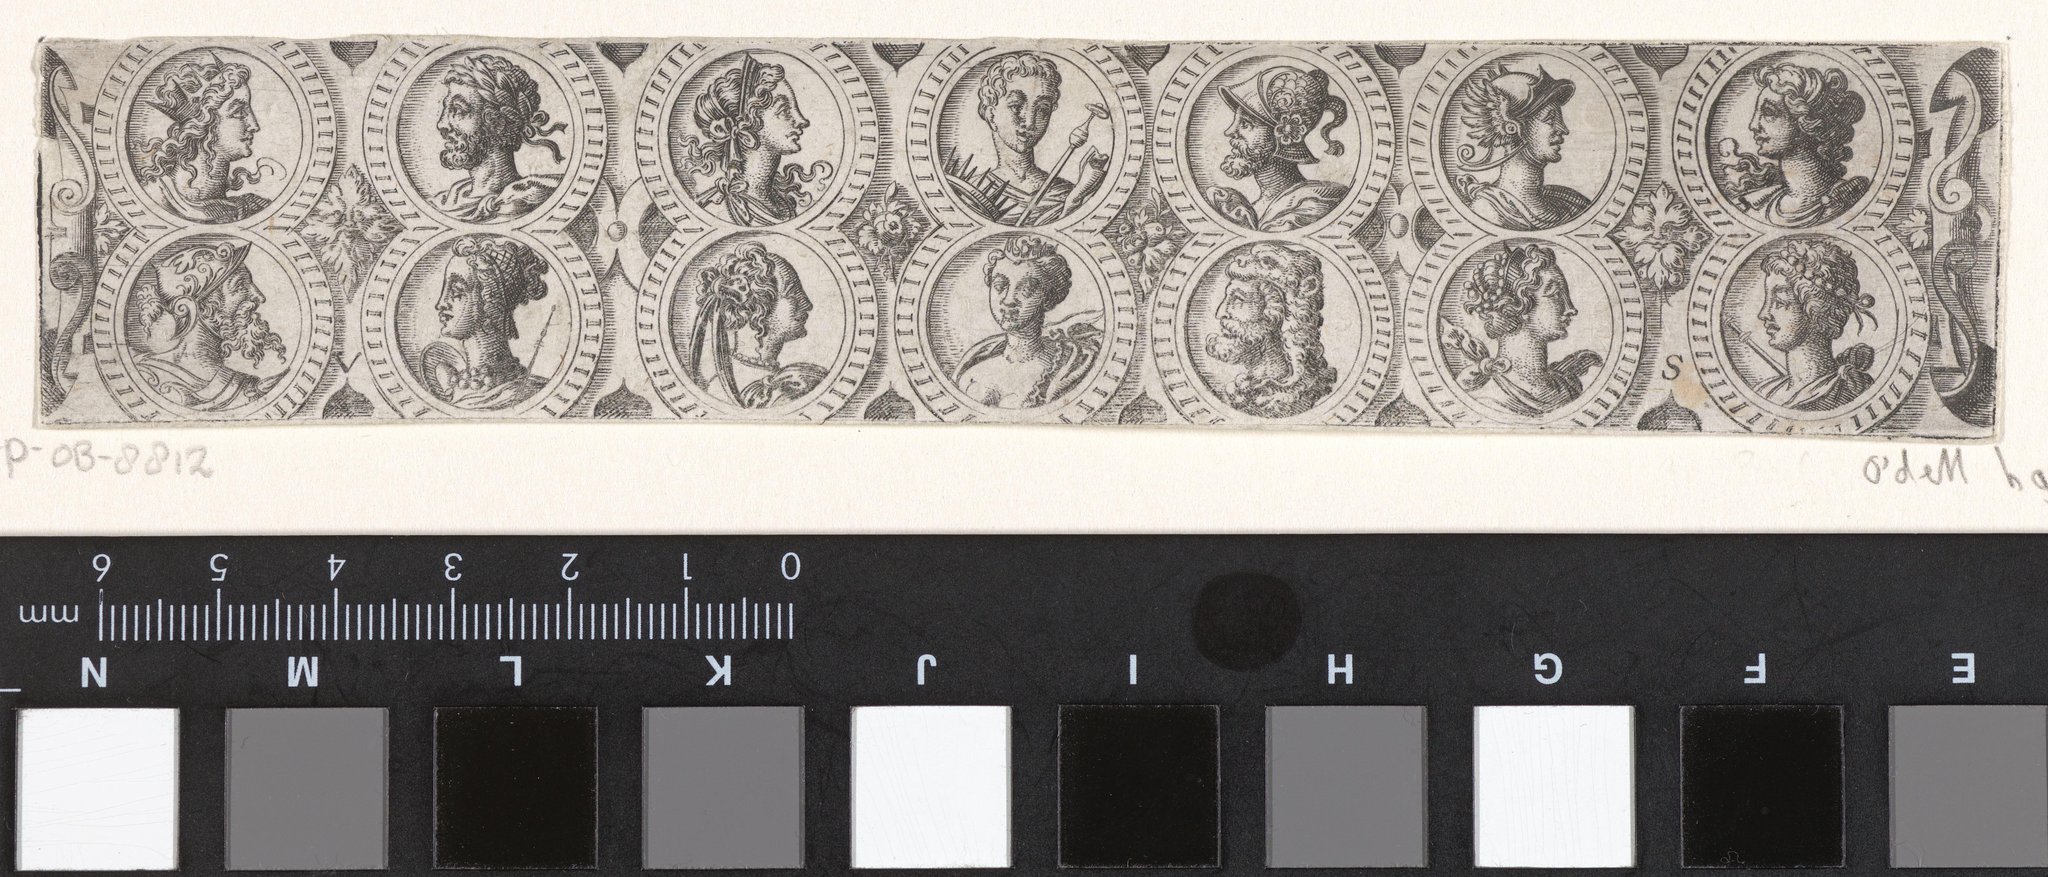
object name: print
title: Fries met veertien koppen in medaillons, derde rechts onder Hercules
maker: virgilius solis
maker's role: draughtsman, print maker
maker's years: 1514-1562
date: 1524-1562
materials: paper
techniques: engraving